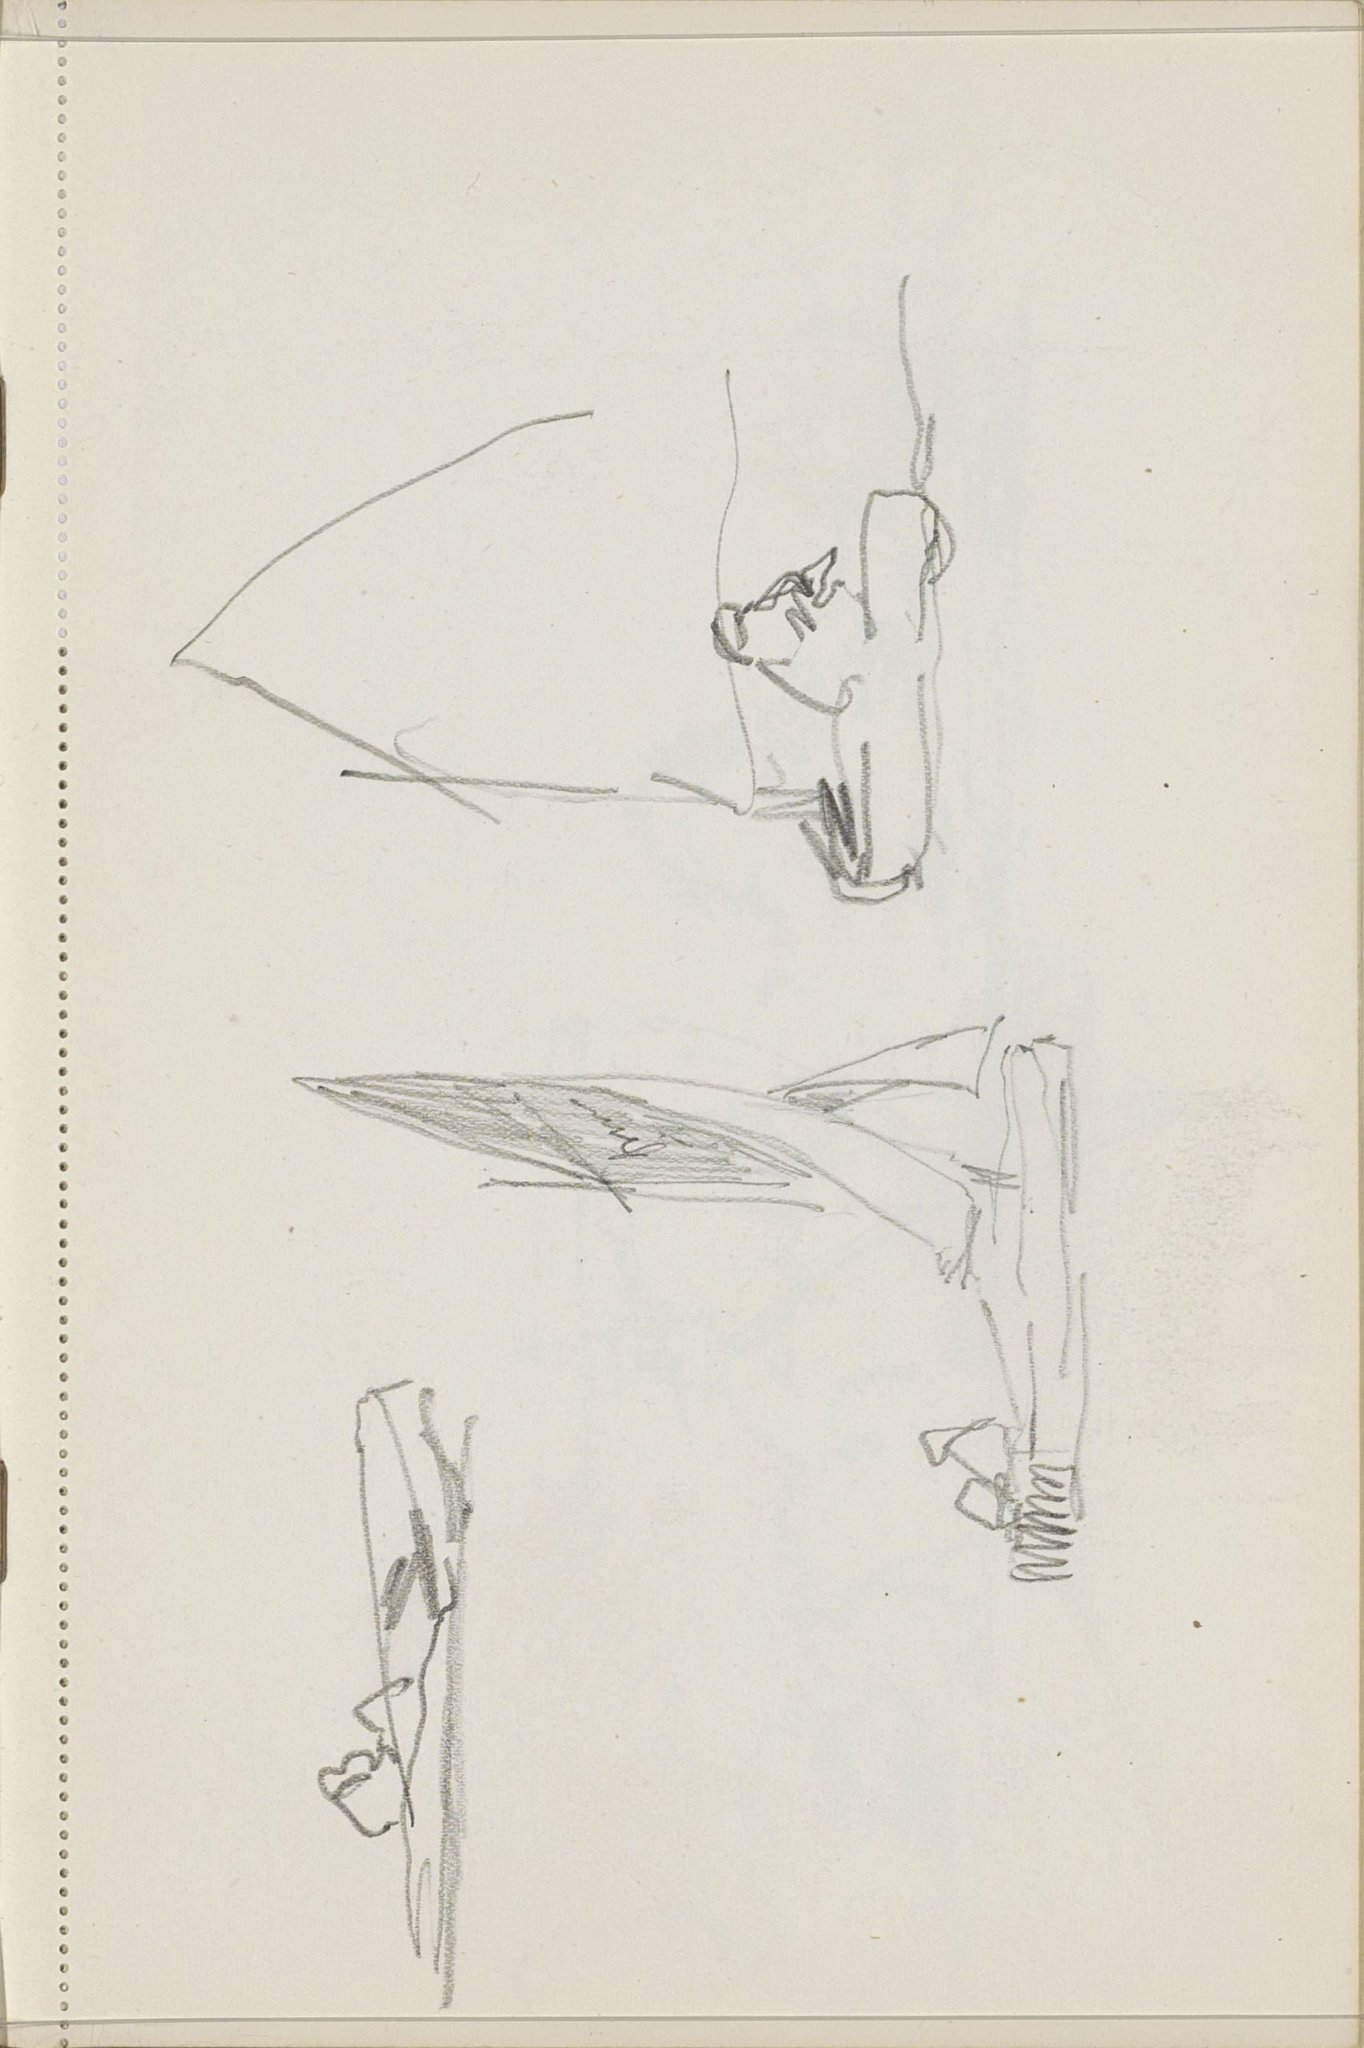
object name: sketchbook leaf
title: Twee zeilschepen en een roeiboot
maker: cornelis vreedenburgh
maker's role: draughtsman, print maker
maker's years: 1880-1946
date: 1890-1946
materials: paper, pencil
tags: sailing-ship, sailing-boat, rowing-boat, canoe, etc.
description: Blad 19 recto uit een schetsboek met uit 75 bladen.